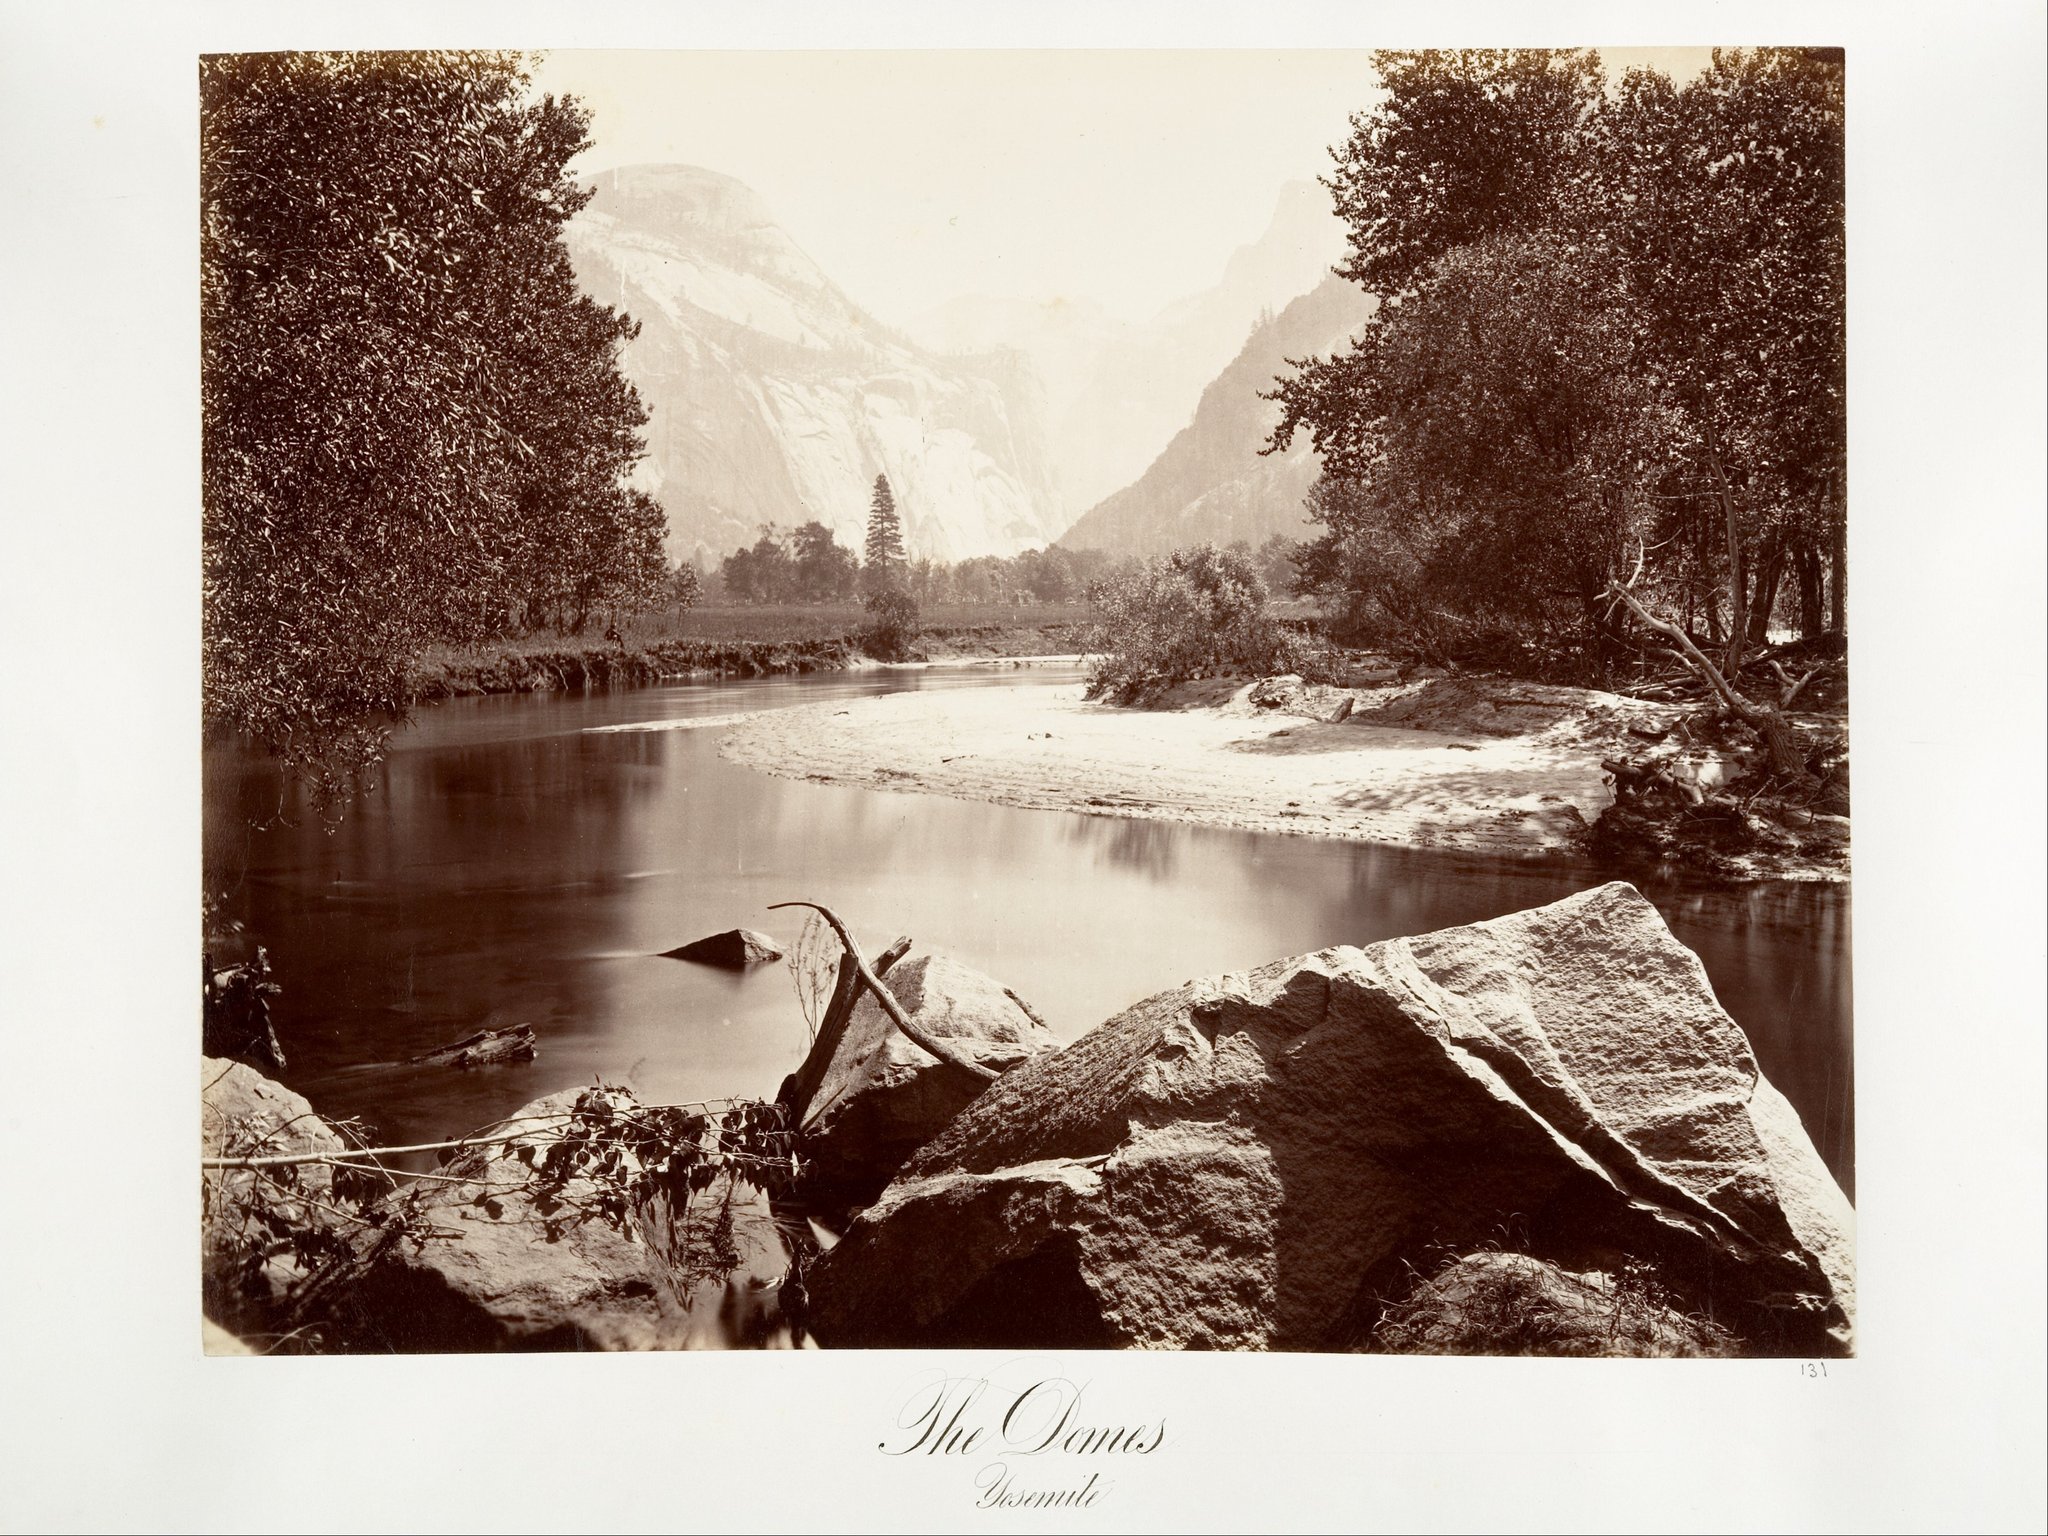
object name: photograph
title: The Domes, Yosemite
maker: carleton e. watkins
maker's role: artist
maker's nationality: american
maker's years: 1829-1916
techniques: albumen silver print, glass negative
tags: mountains,landscapes